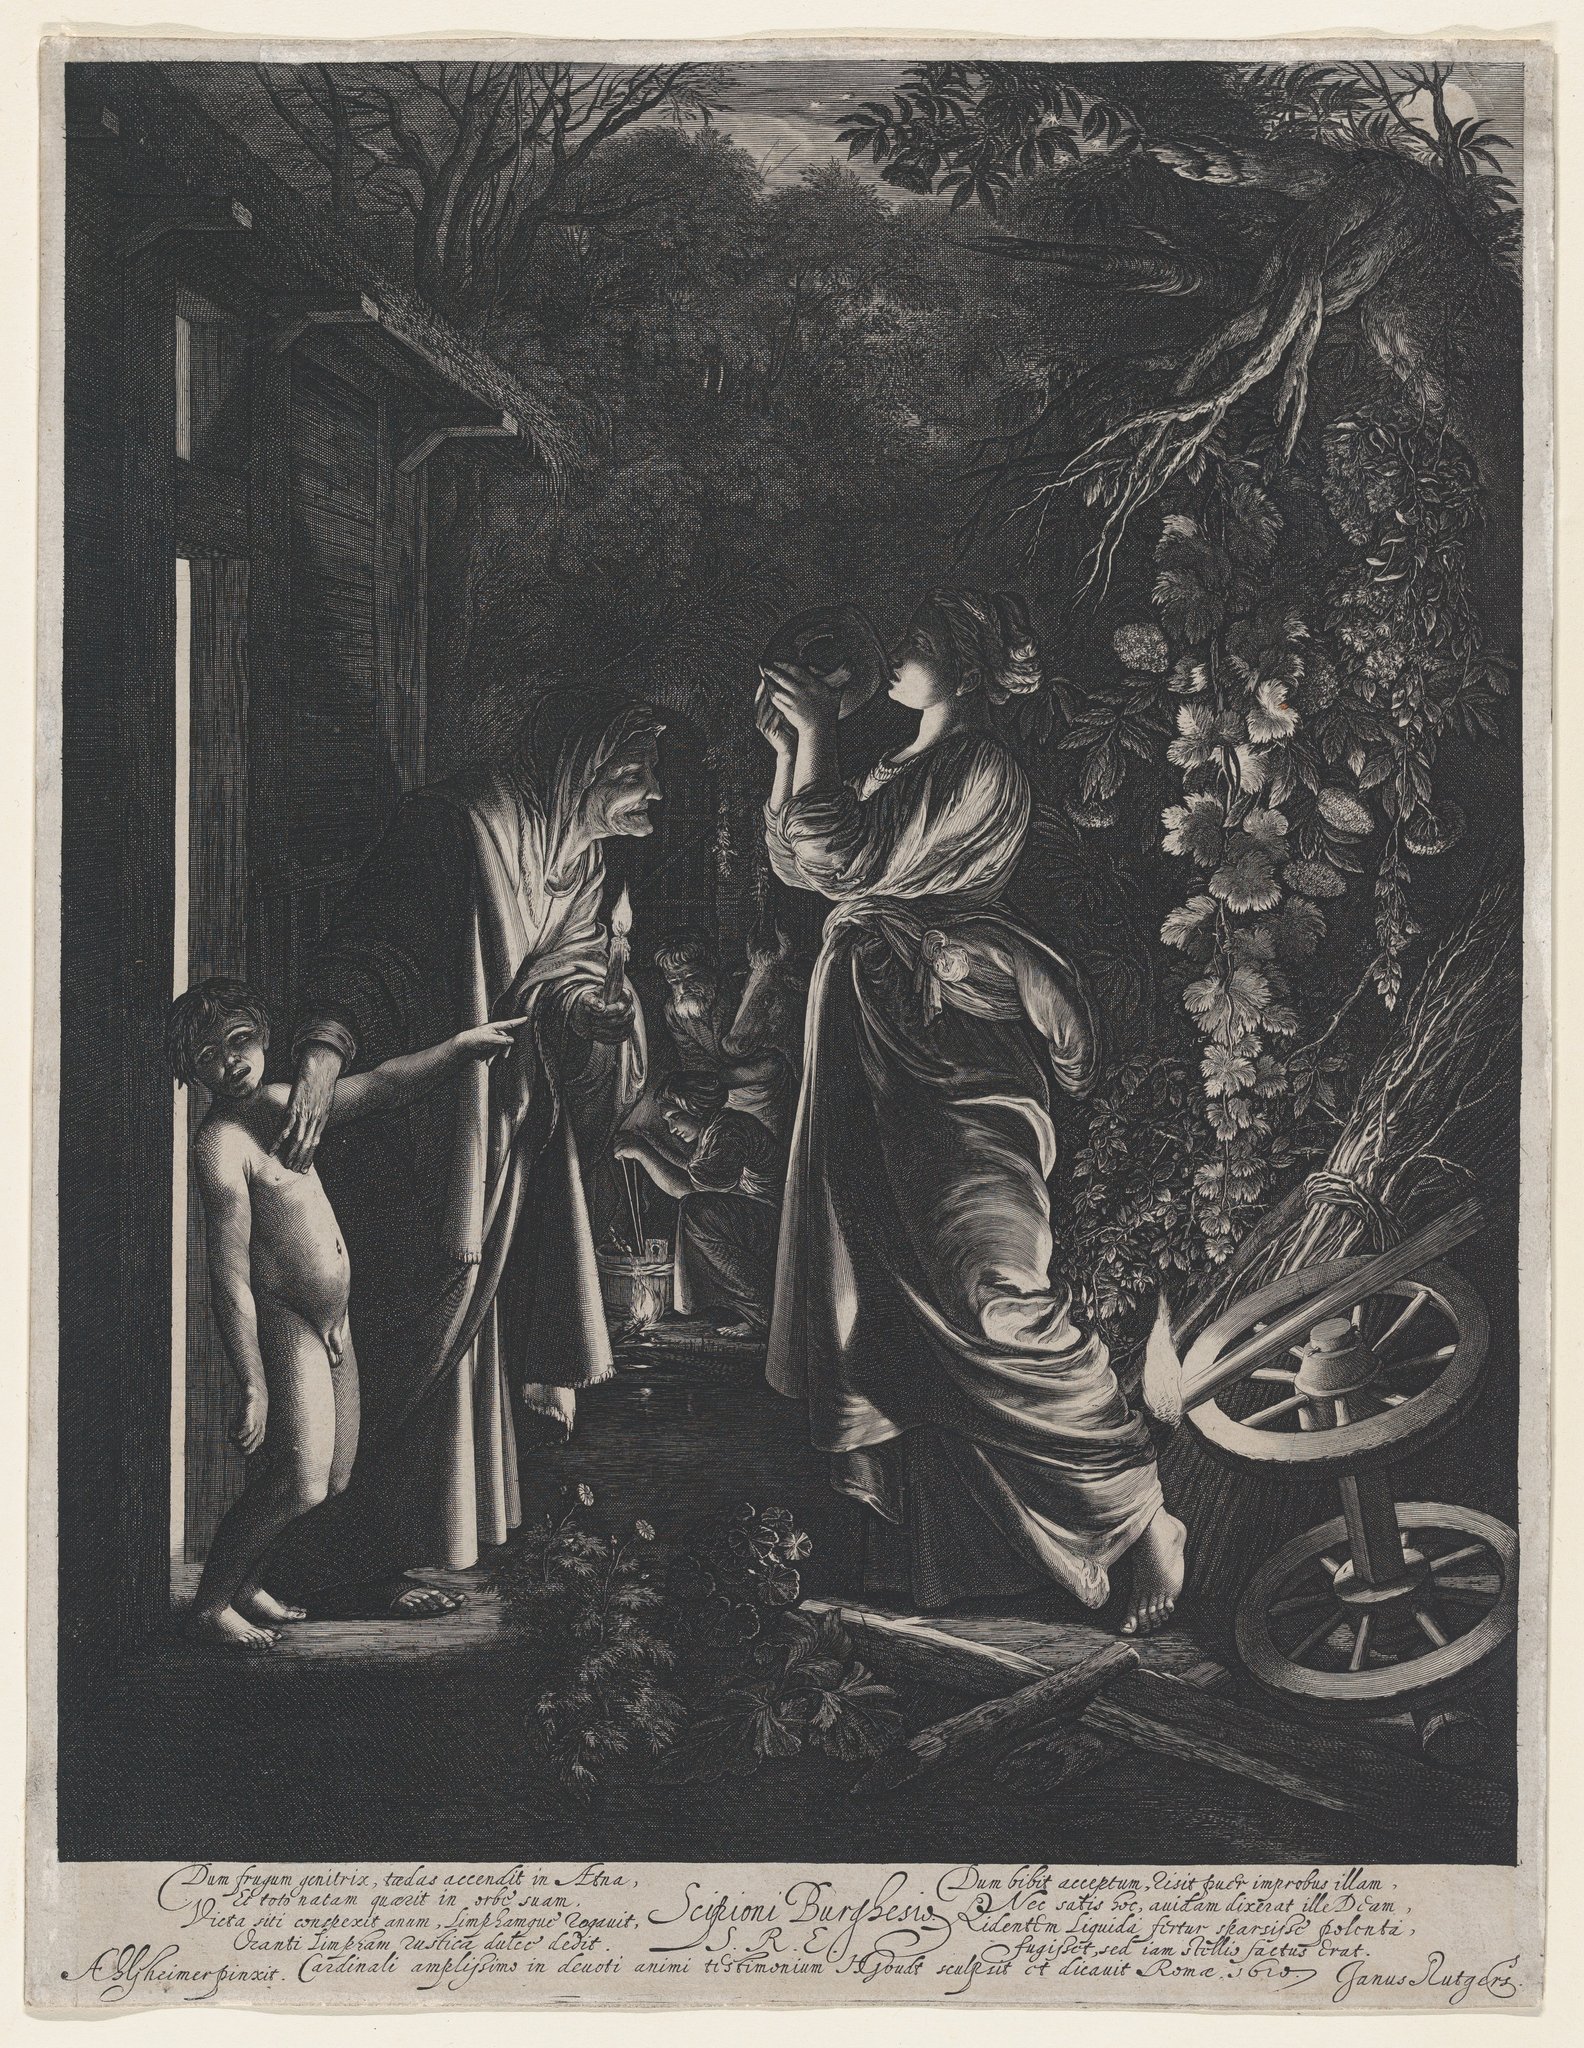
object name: print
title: Ceres Seeking Her Daughter (The Mocking of Ceres)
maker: hendrick goudt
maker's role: artist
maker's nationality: dutch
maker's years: 1580-1648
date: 1610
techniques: engraving